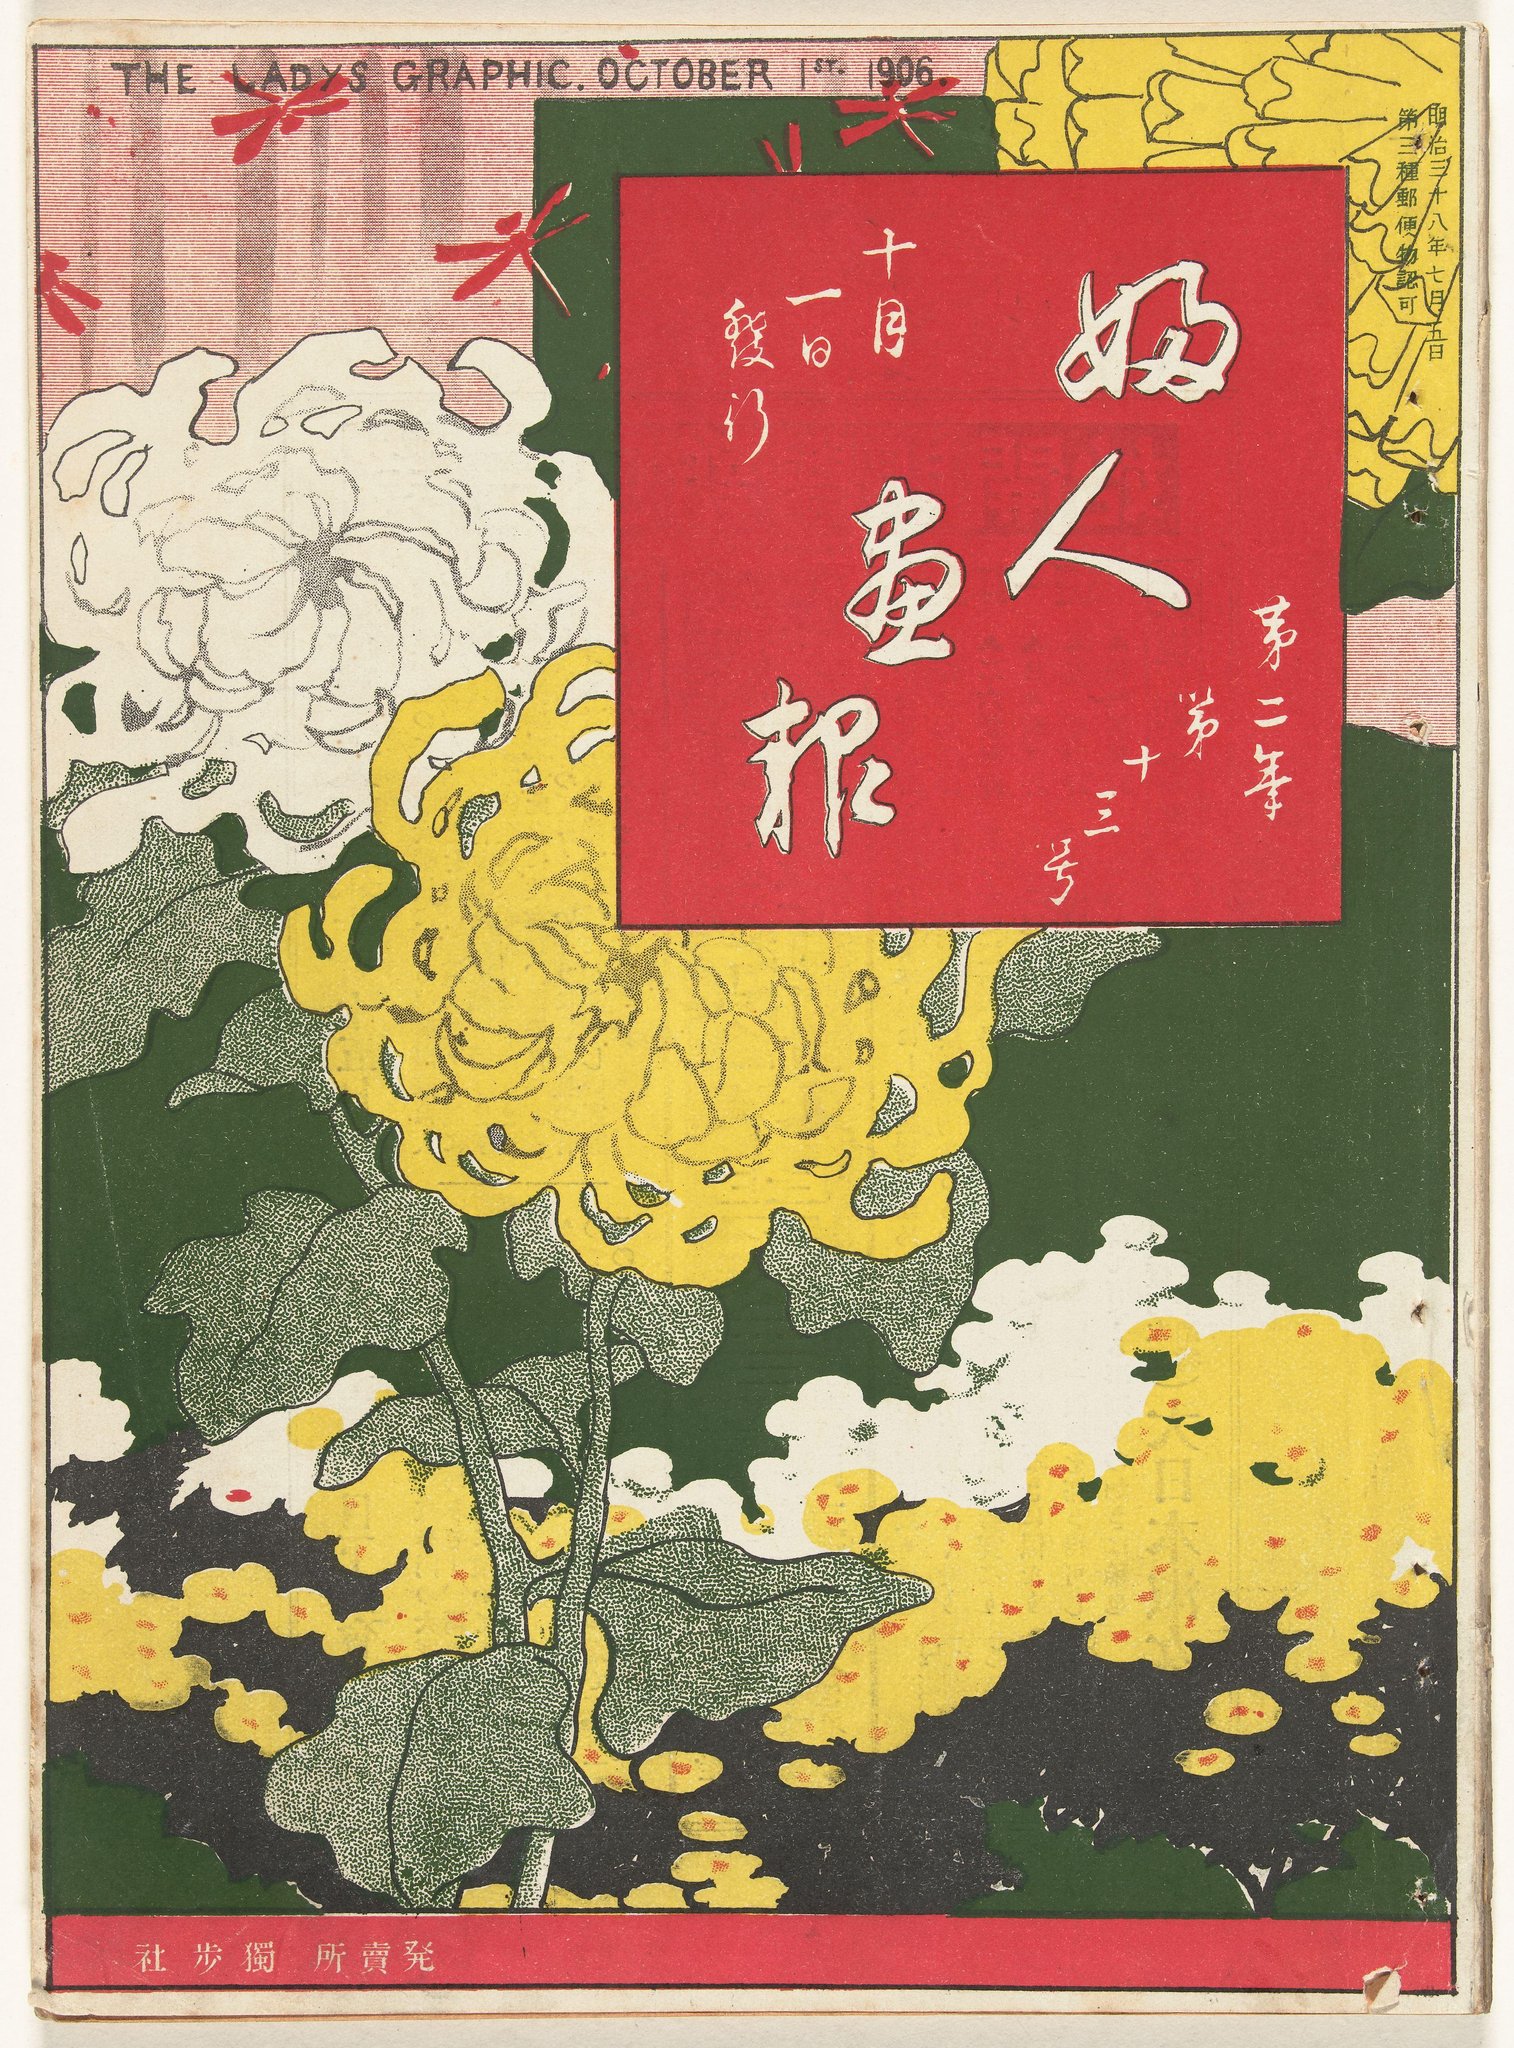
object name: magazine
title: Oktober 1906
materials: paper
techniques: letterpress printing, lithograph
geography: japan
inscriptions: date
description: Nummer 13 van de tweede jaargang (oktober 1906) van het tijdschrift Fujin gaho: kaft met afbeelding van witte en gele chrysanten, rechtsboven in een rood cartouche de titel; binnenin, frontspies van boompartij bij meer.